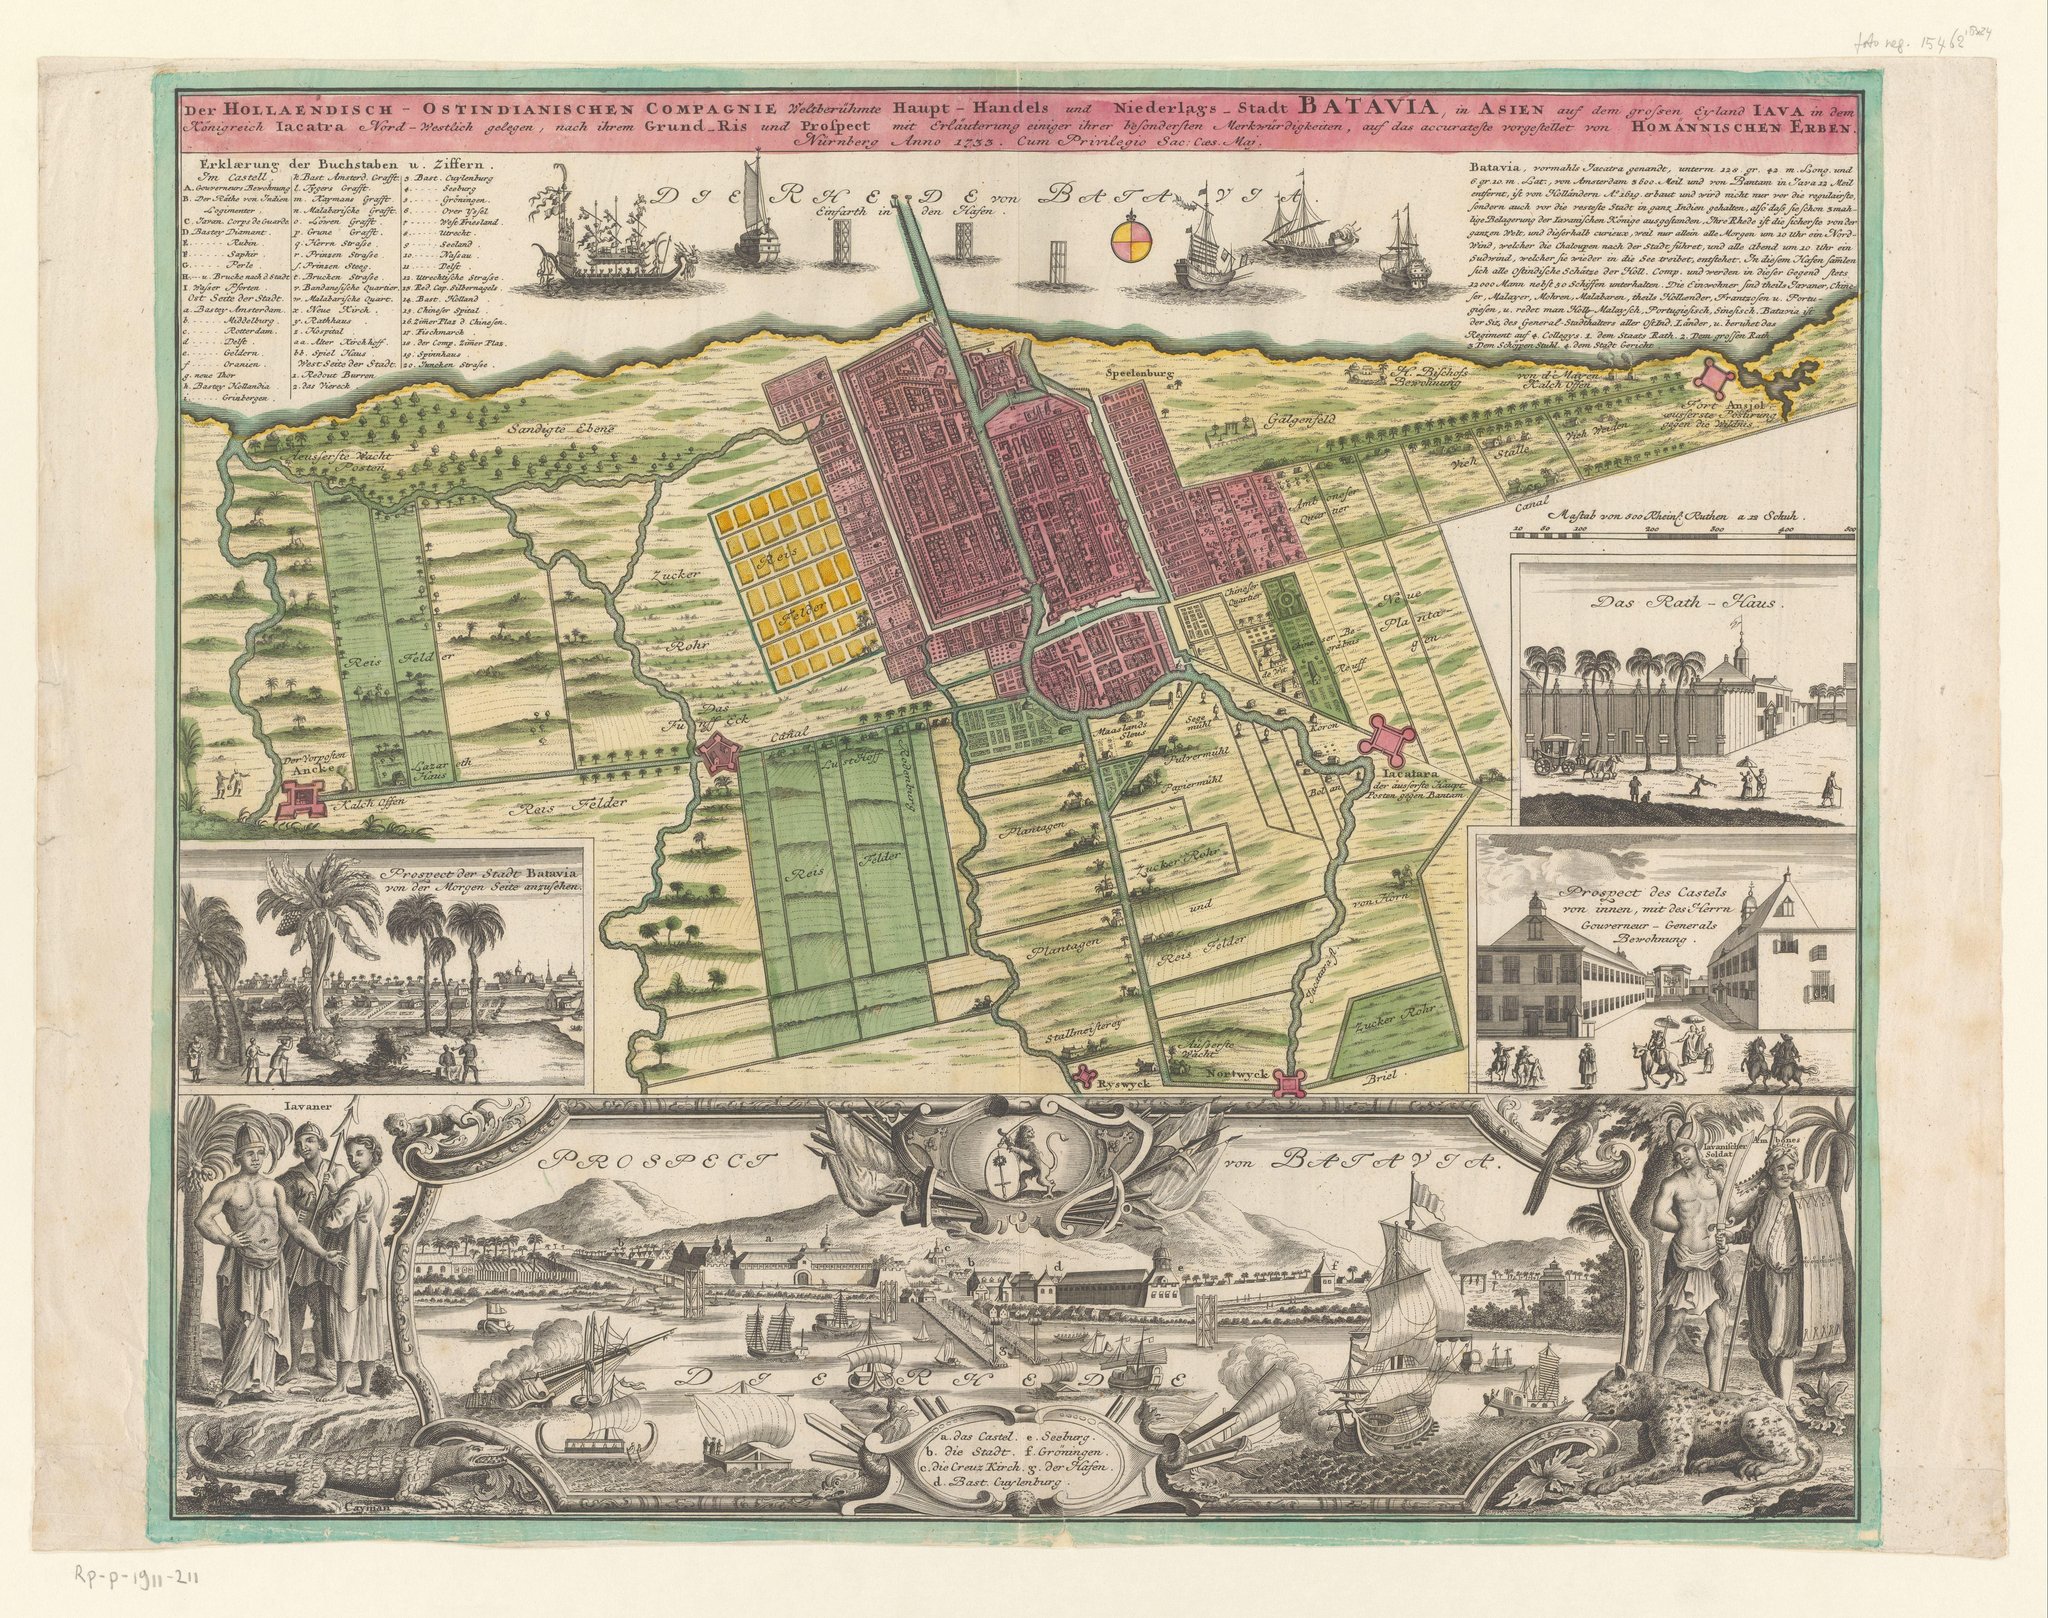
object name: area plan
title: Plattegrond van en gezicht op Batavia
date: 1733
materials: paper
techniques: engraving, etching, hand coloring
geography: nuremberg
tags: coat of arms (as symbol of the state, etc.) (+ city; municipal), maps of cities, prospect of city, town panorama, silhouette of city, batavia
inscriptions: collector's mark: Lugt 2228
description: Boven een plattegrond van Batavia. Onder een gezicht op Batavia, met bovenin een Hollandse leeuw met het wapen van Batavia en links en rechts figuren die de oorspronkelijke inwoners van Java verbeelden. Langs de rechterrand een gezicht op het Kasteel en het raadhuis van Batavia.